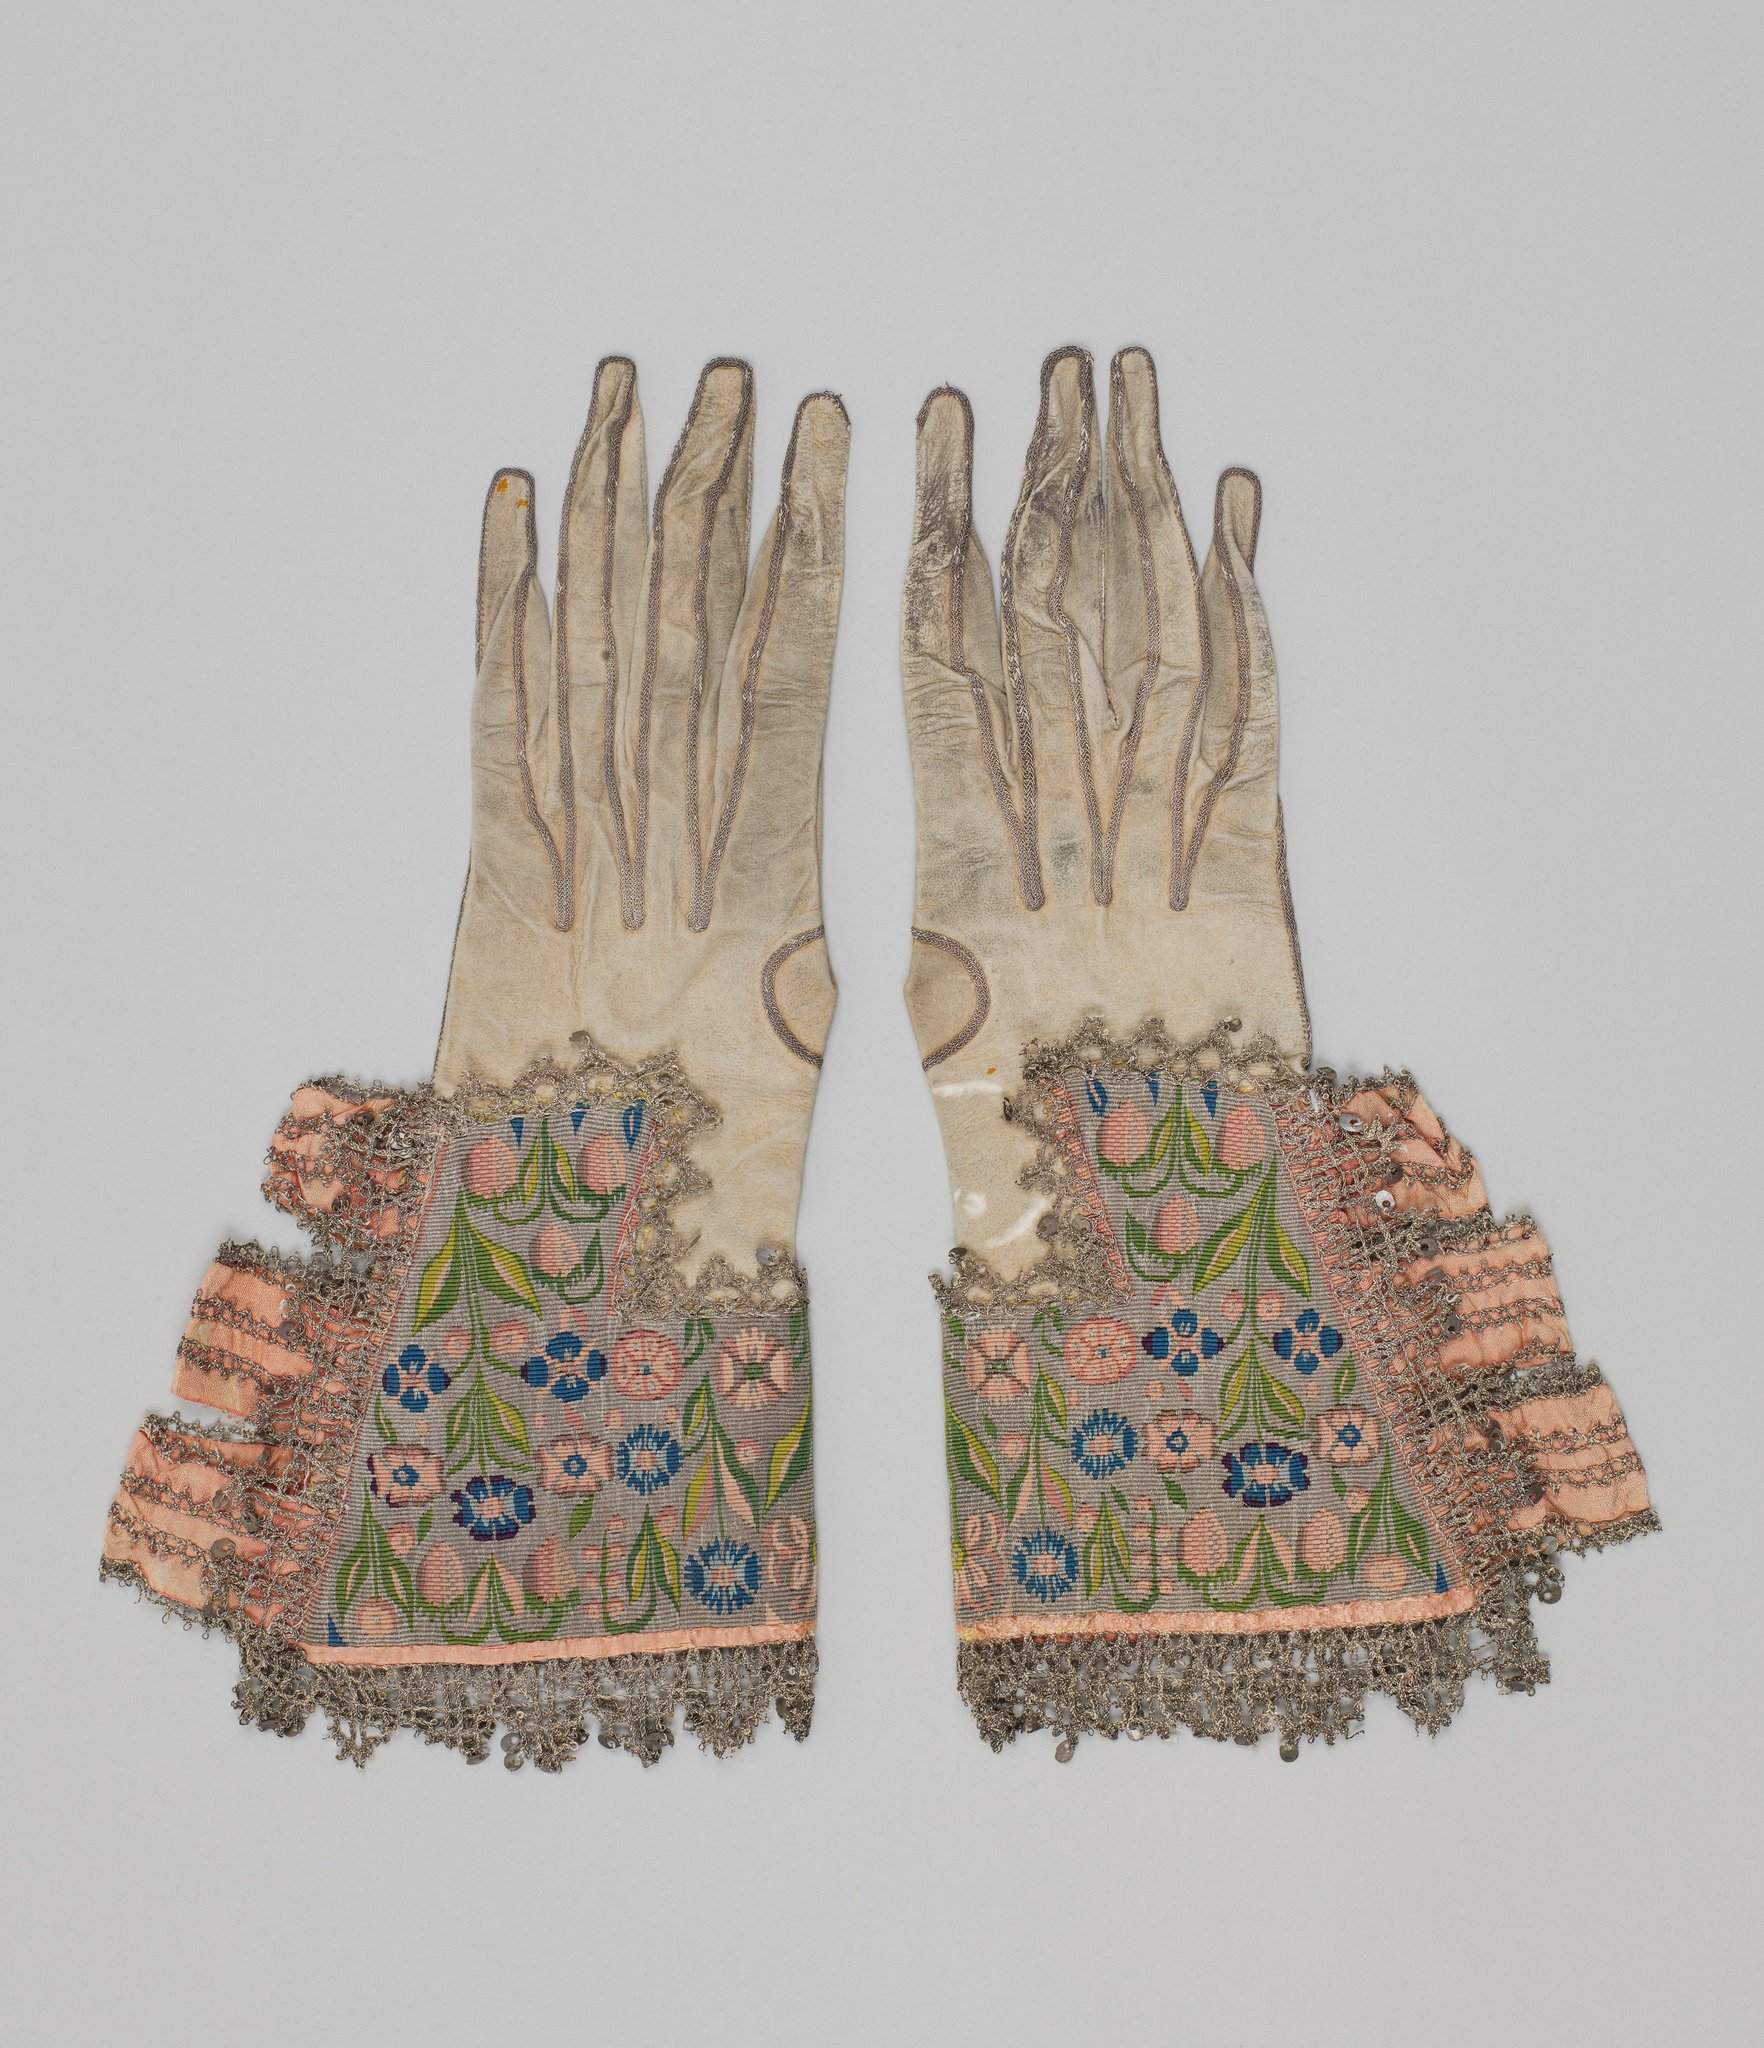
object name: glove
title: Pair of gloves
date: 1601-1633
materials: leather, metal thread, silk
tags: flowers